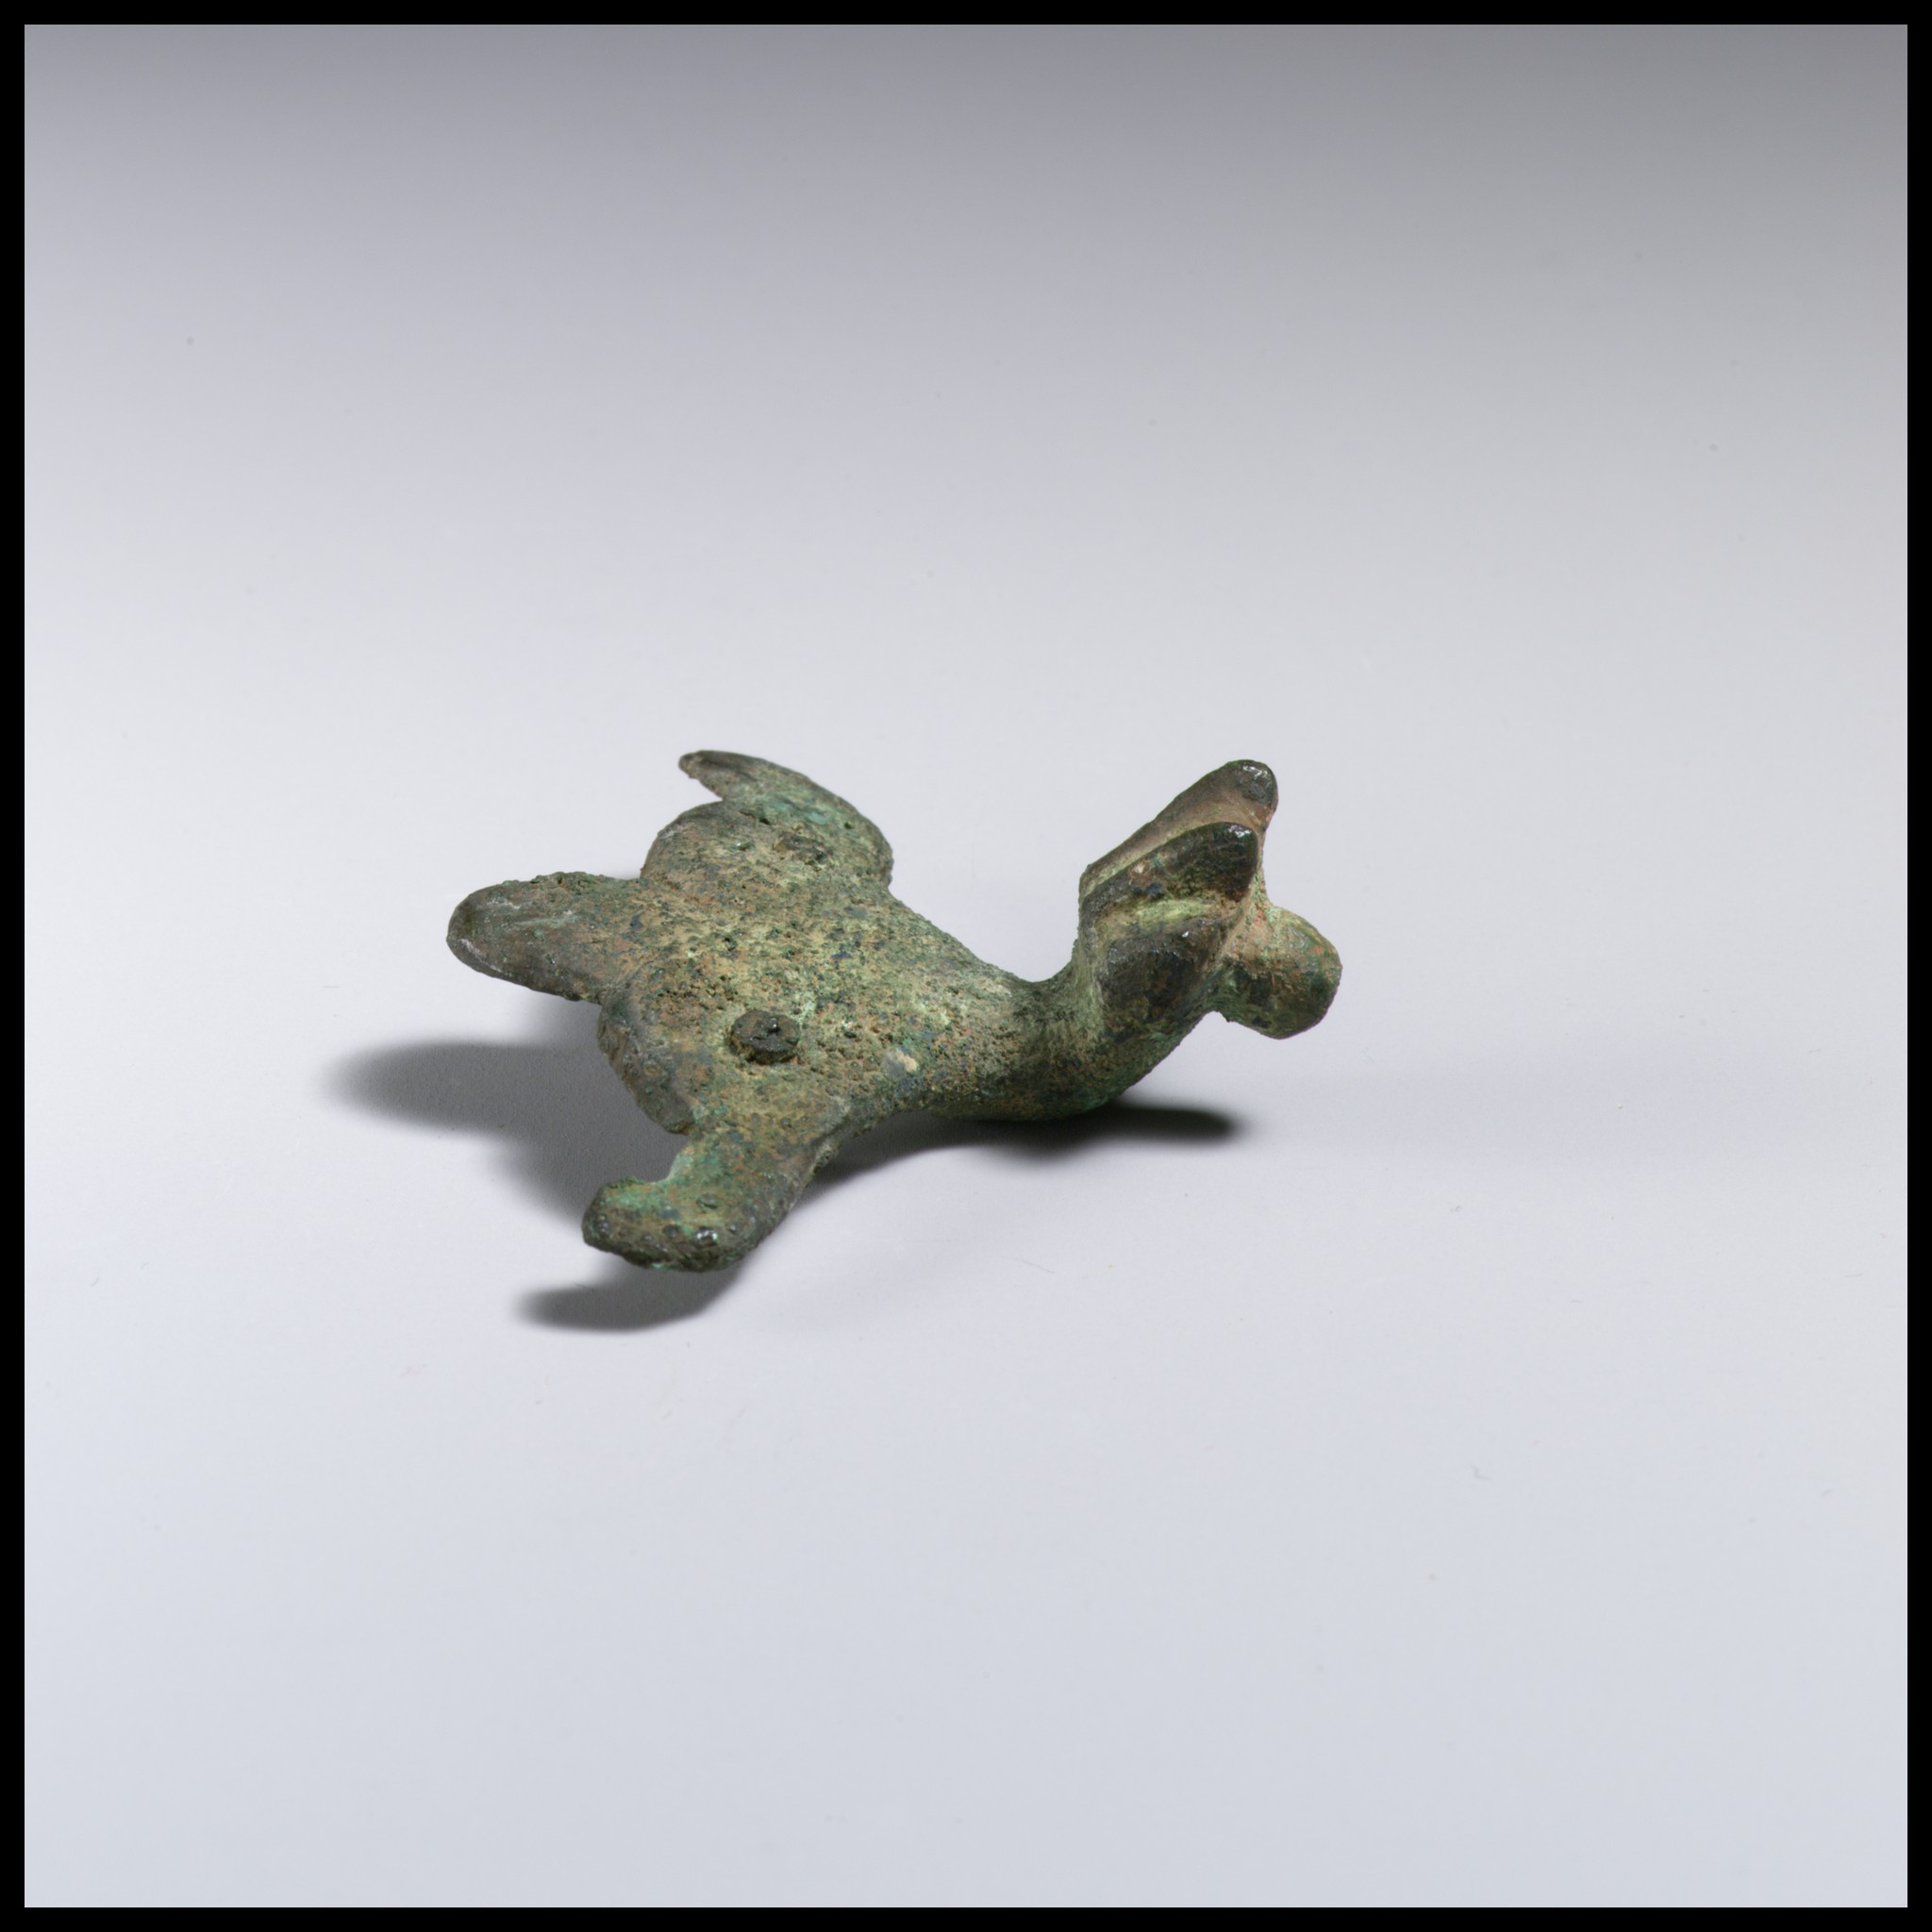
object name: cista, foot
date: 7000 BCE-330 CE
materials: bronze